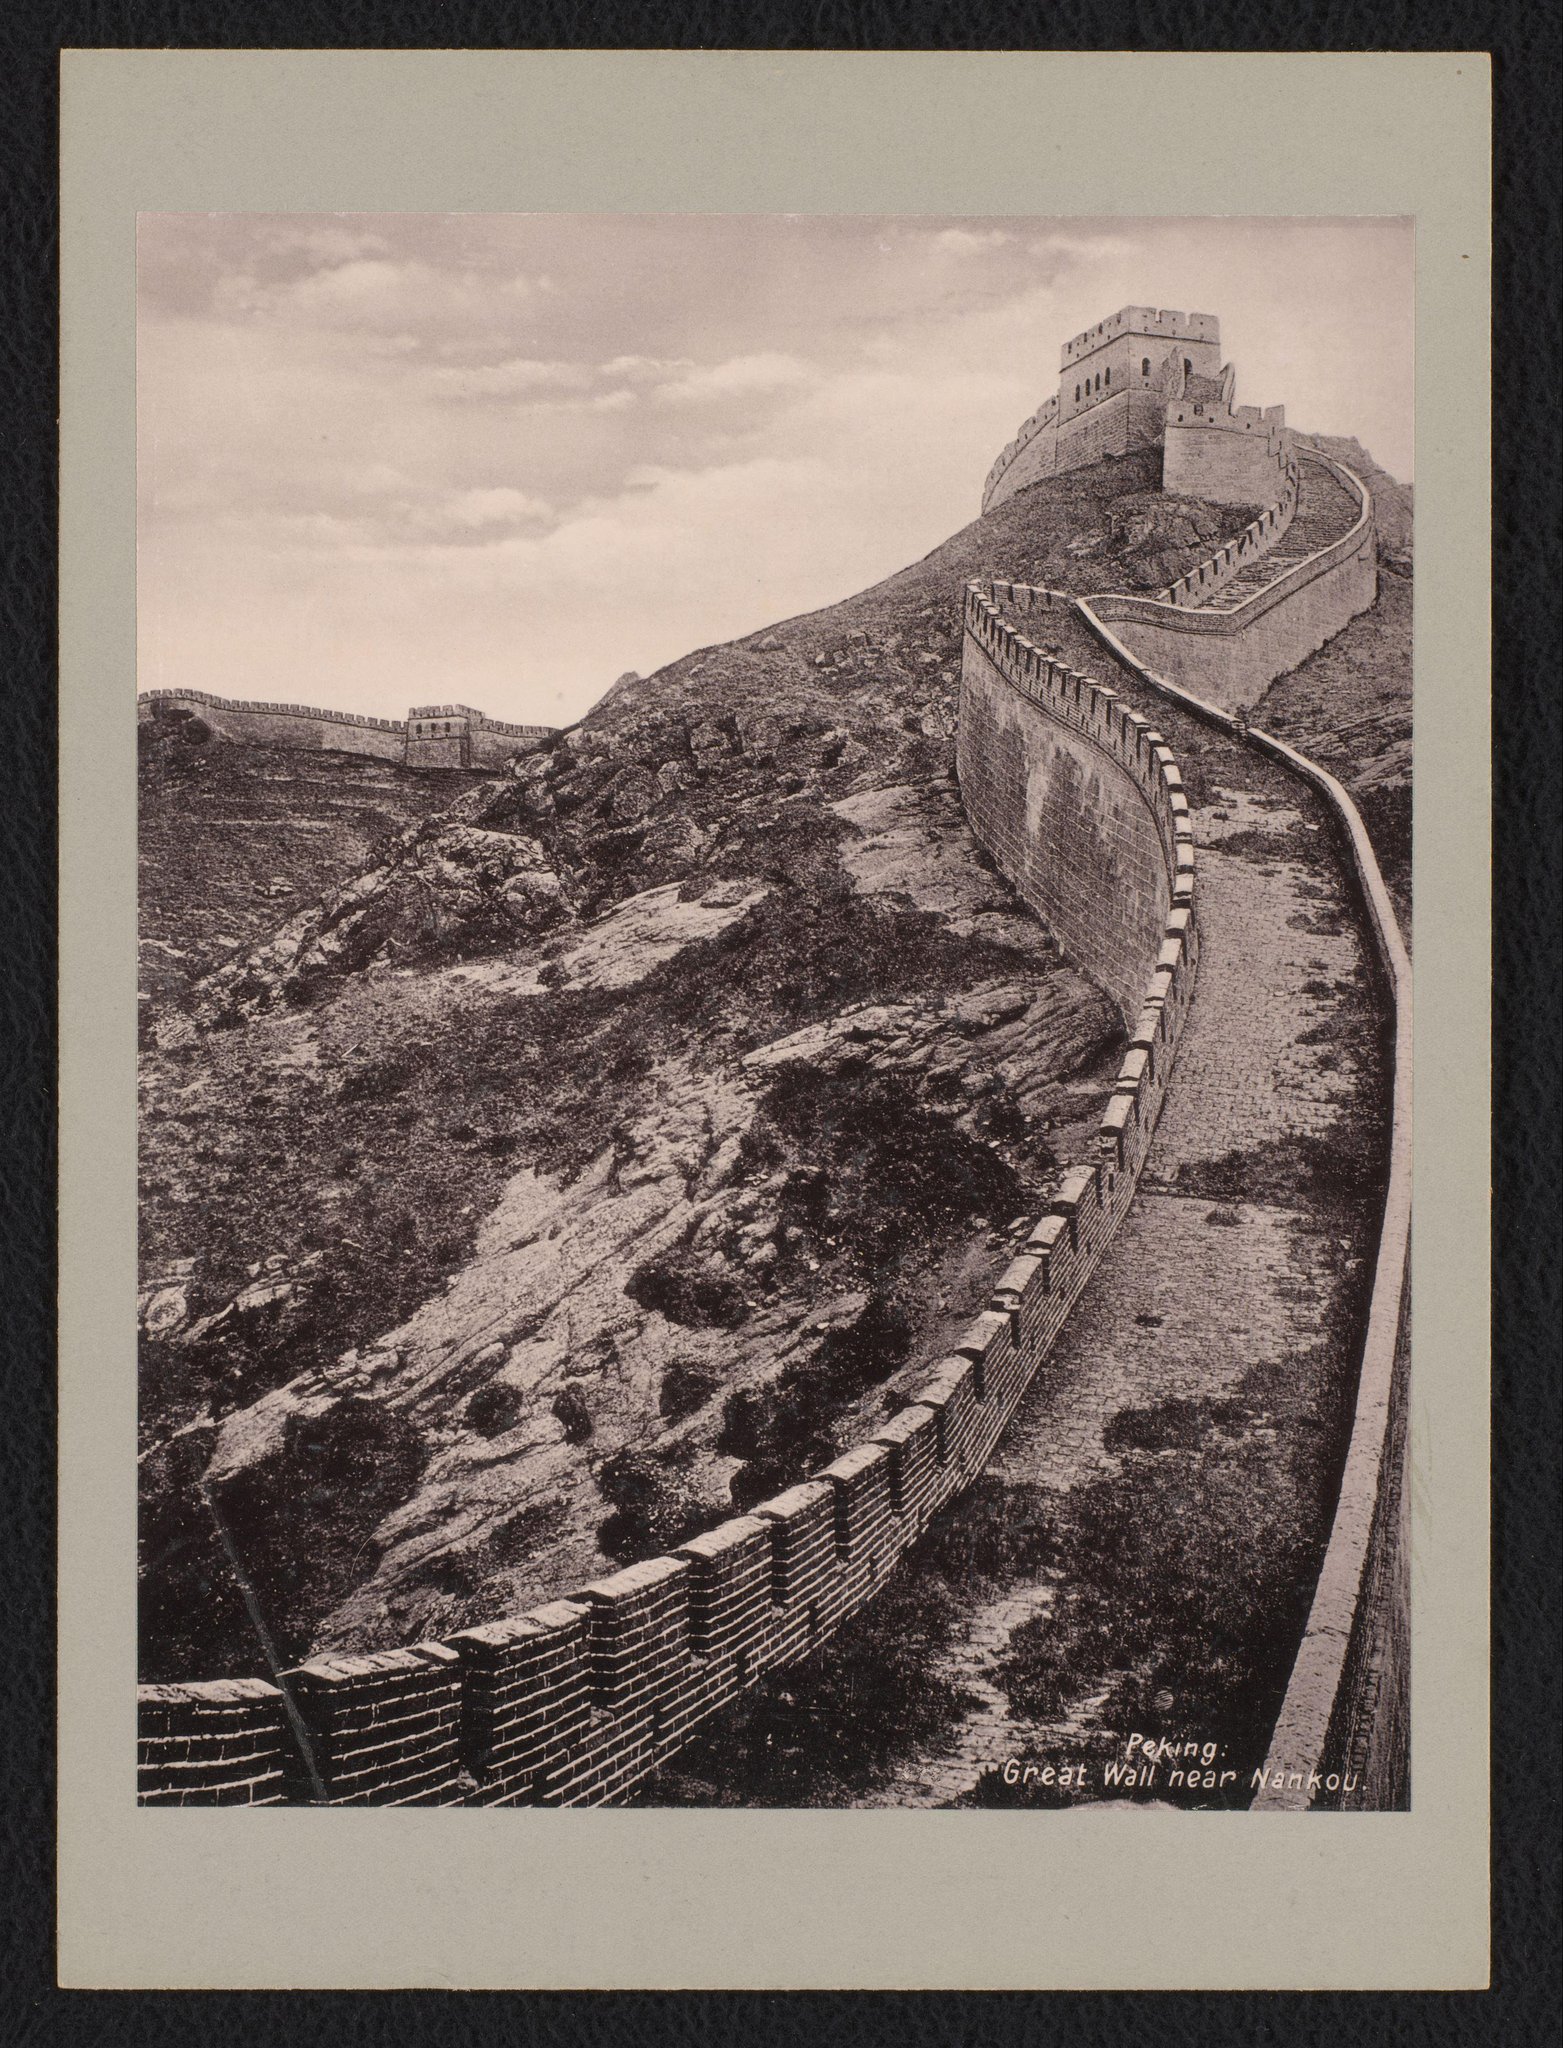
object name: photograph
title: Chinese Muur vlakbij Nankou, Peking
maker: Anonymous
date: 1895-1915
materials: cardboard, photographic support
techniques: photograph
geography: beijing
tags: peking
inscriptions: number: ‘14.’